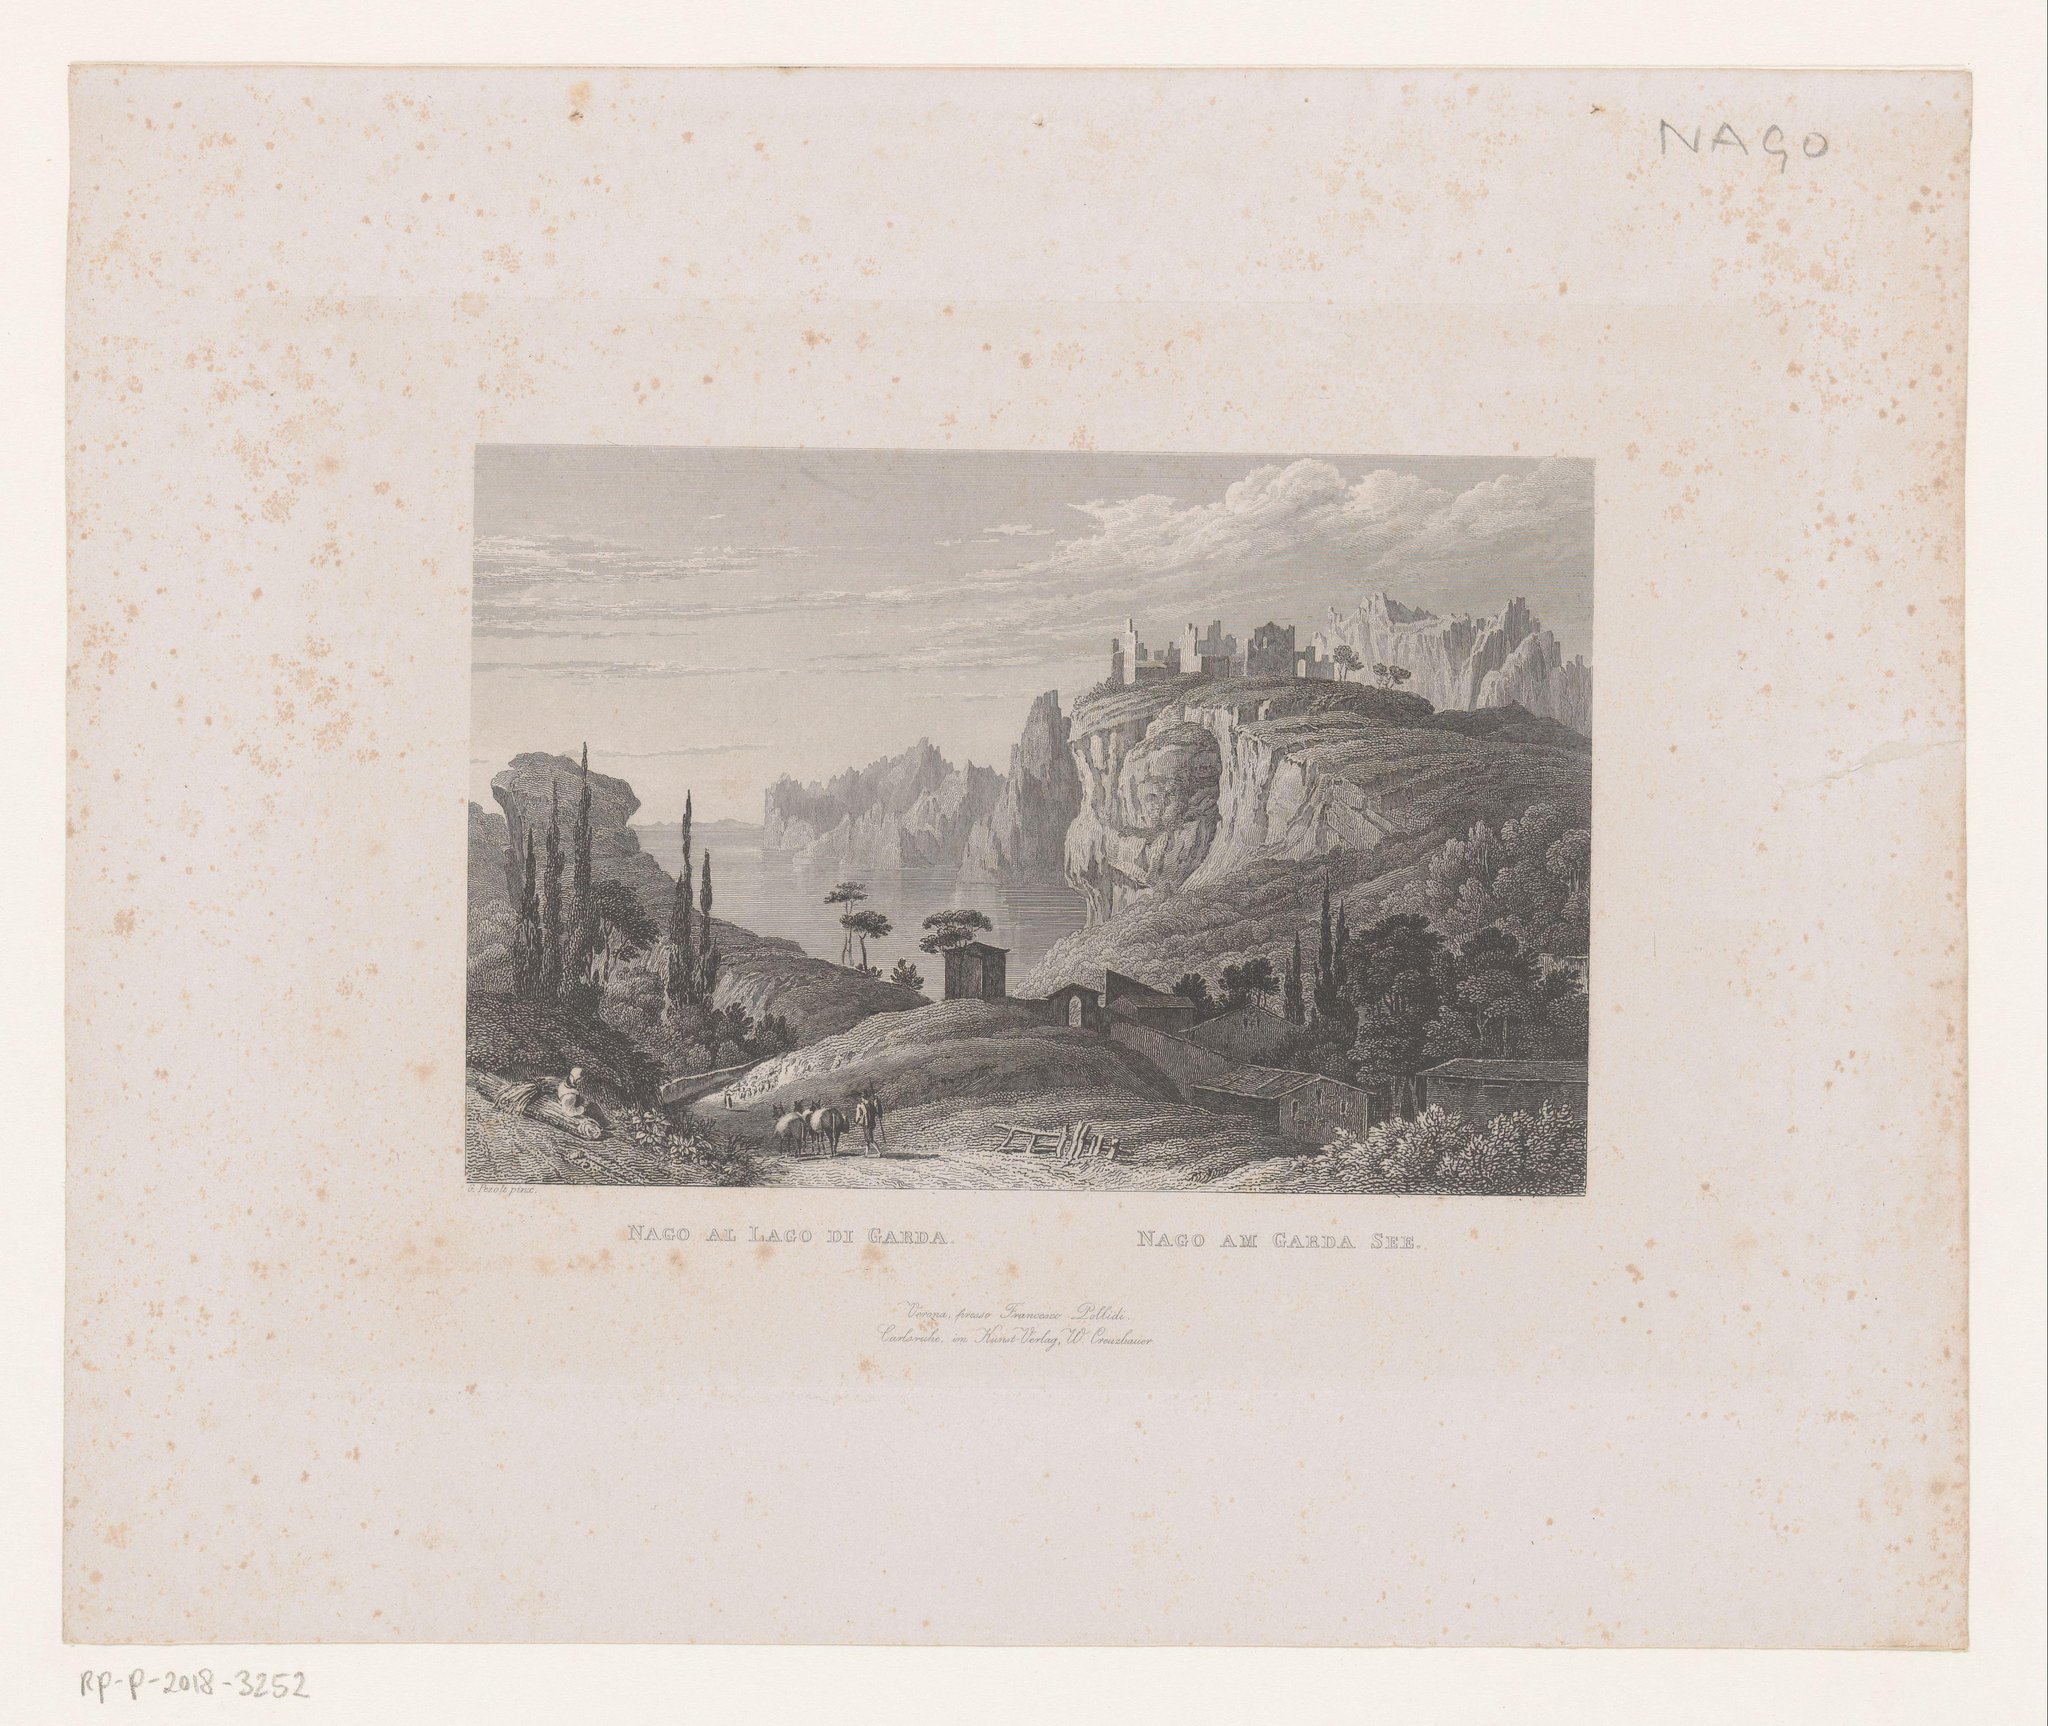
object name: print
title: Gezicht op het Gardameer vanuit Nago-Torbole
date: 1835-1860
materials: paper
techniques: engraving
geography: verona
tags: landscapes with waters, waterscapes, seascapes (in the temperate zone), lake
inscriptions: collector's mark: Lugt 2228